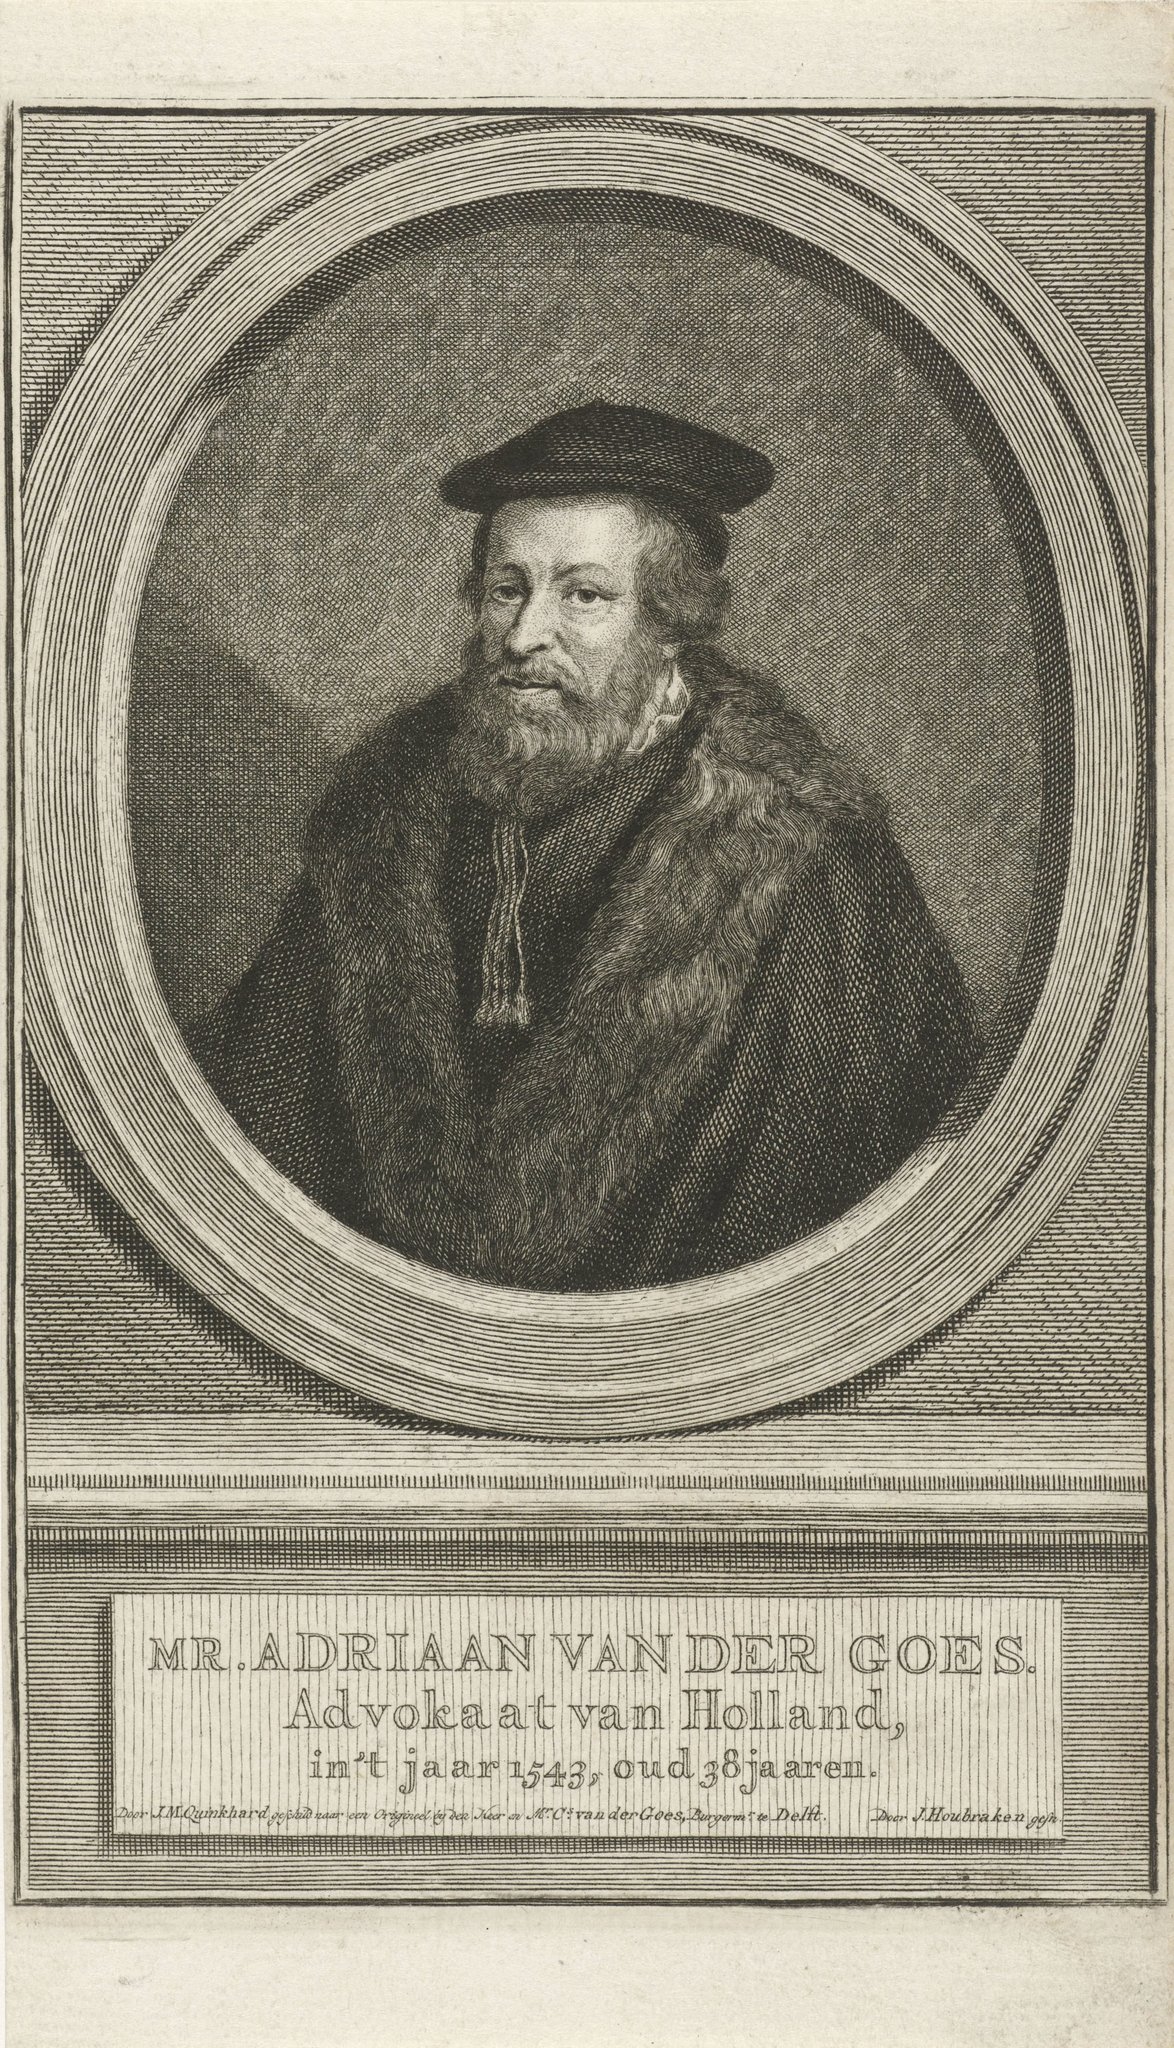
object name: print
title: Mr. Adriaan van der Goes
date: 1790-1796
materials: paper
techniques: engraving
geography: amsterdam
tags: delft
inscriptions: collector's mark: Lugt 2228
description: Prent oorspronkelijk gebruikt in: Jan Wagenaar, Vaderlandsche historie, vervattende de geschiedenissen der nu Vereenigde Nederlanden, inzonderheid die van Holland (...), 21 delen. Amsterdam, Isaak Tirion, 1749-59. Maar hier naam uitgever verwijderd, waarschijnlijk gebruikt in latere editie. Zie Van Someren 8d.